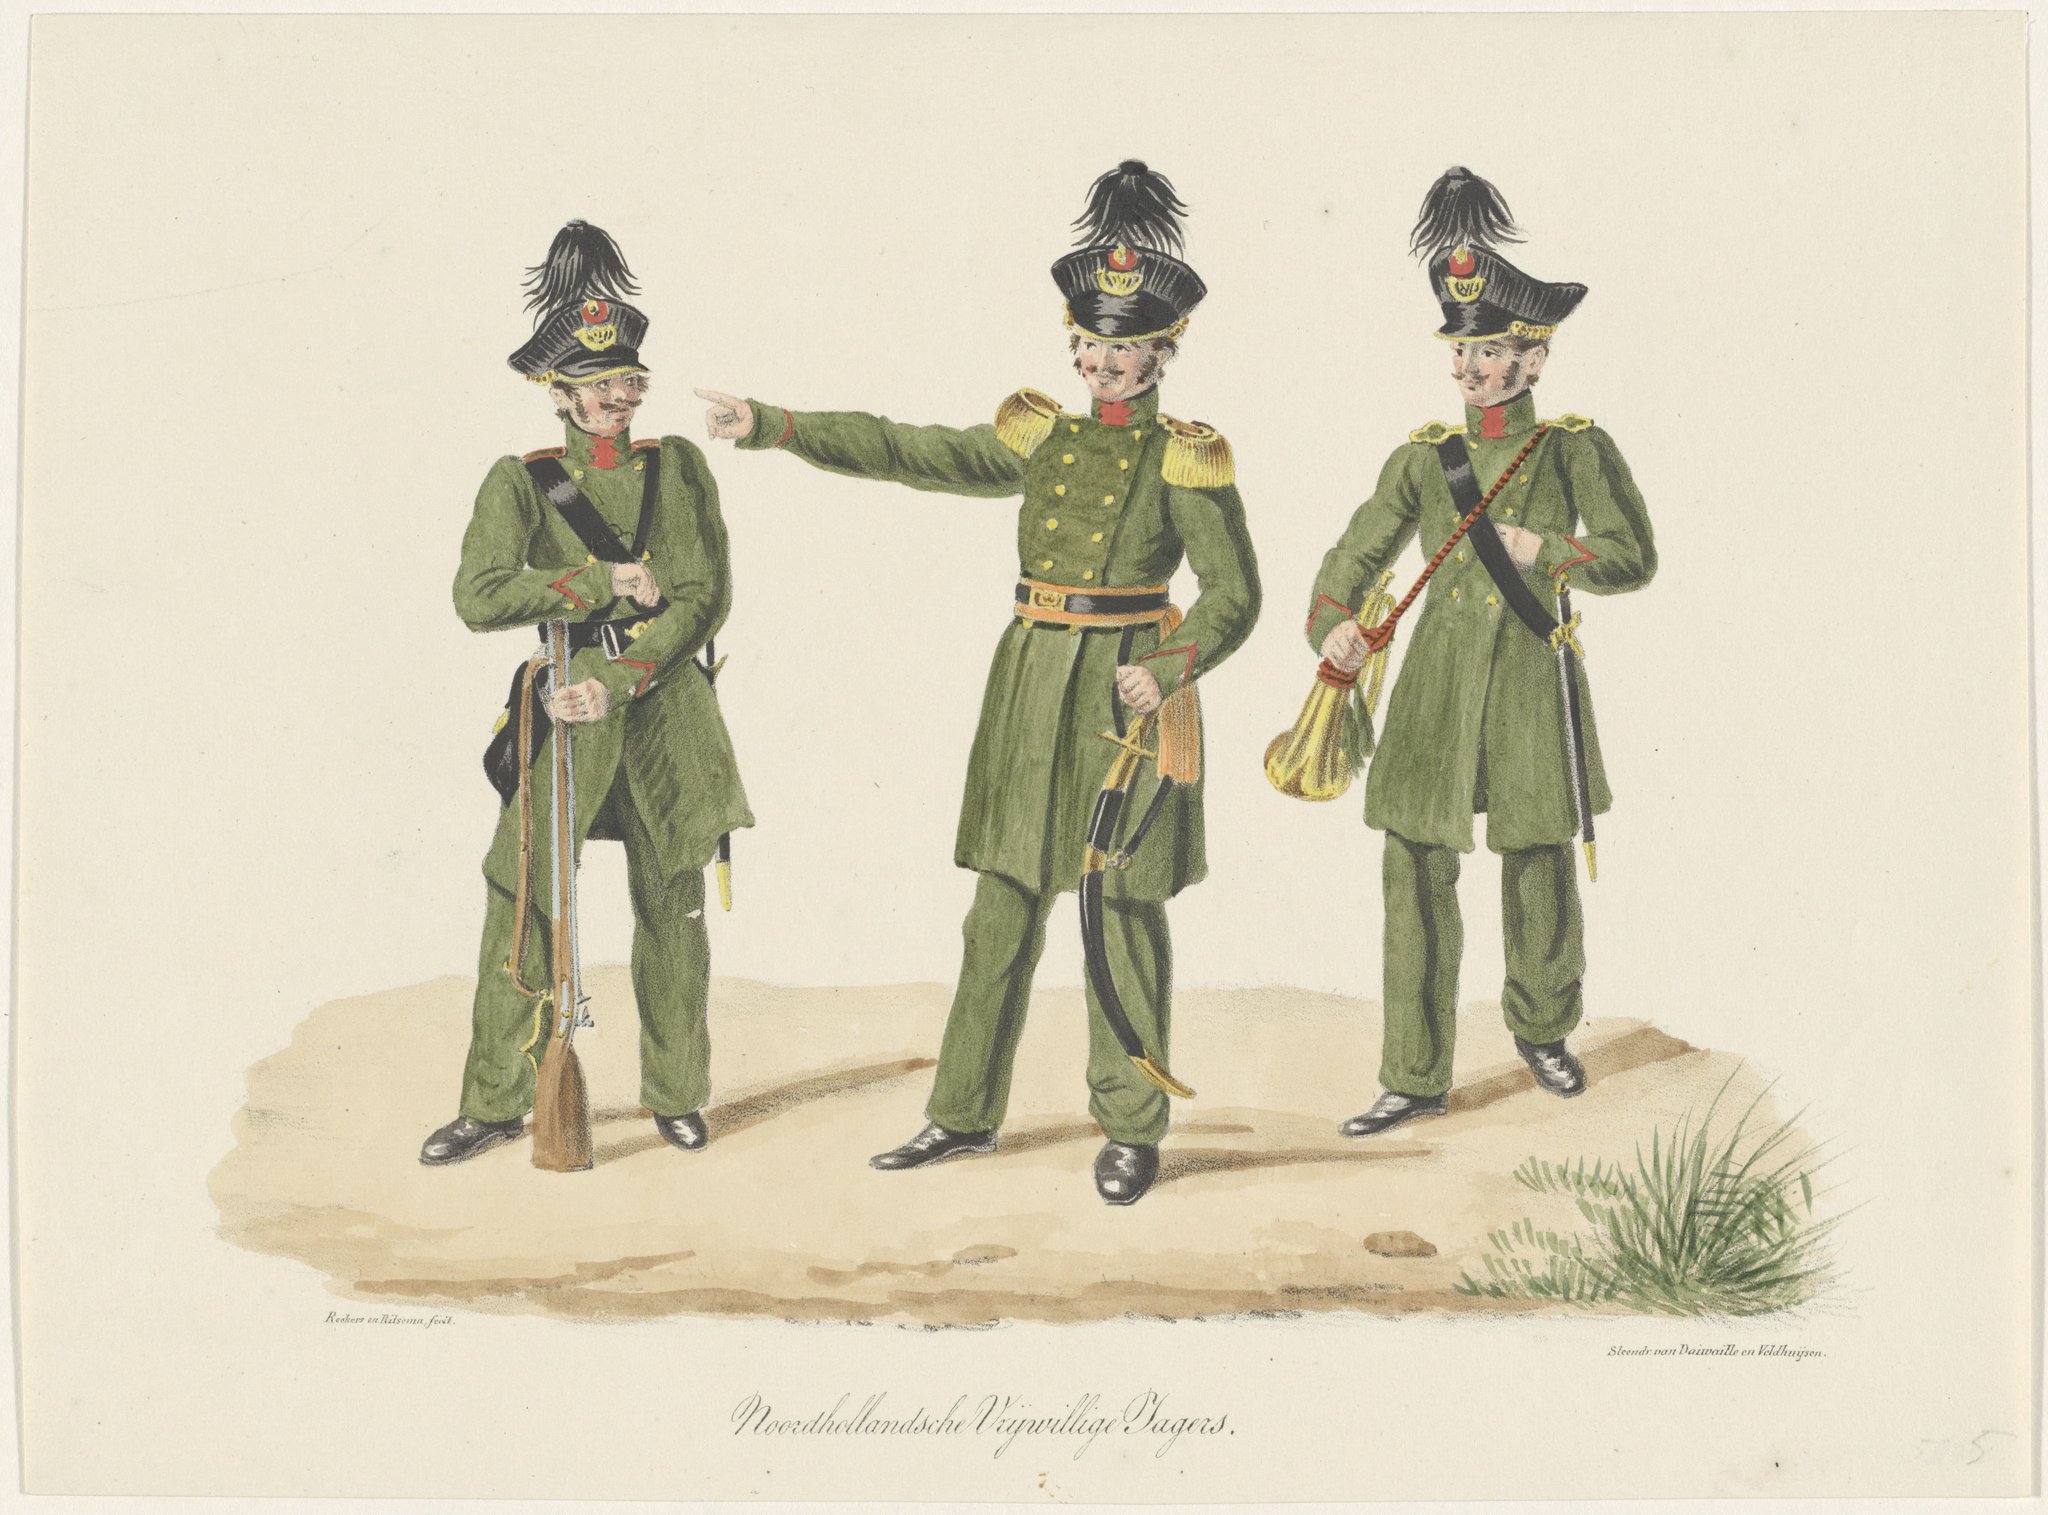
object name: costume print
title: Vrijwillige Jagers van Noord-Holland, 1830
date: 1830-1831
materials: paper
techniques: hand coloring, lithograph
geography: netherlands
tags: (military) uniforms, clothes, costume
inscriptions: collector's mark: Lugt 2228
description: Makers op de prent vermeld als 'Reckers en Ritsema'. Waarschijnlijk zijn dit Johannes Reekers (Sr.) en Jacob Ritsema. Muller geeft 'Reekers' ipv 'Reckers'.